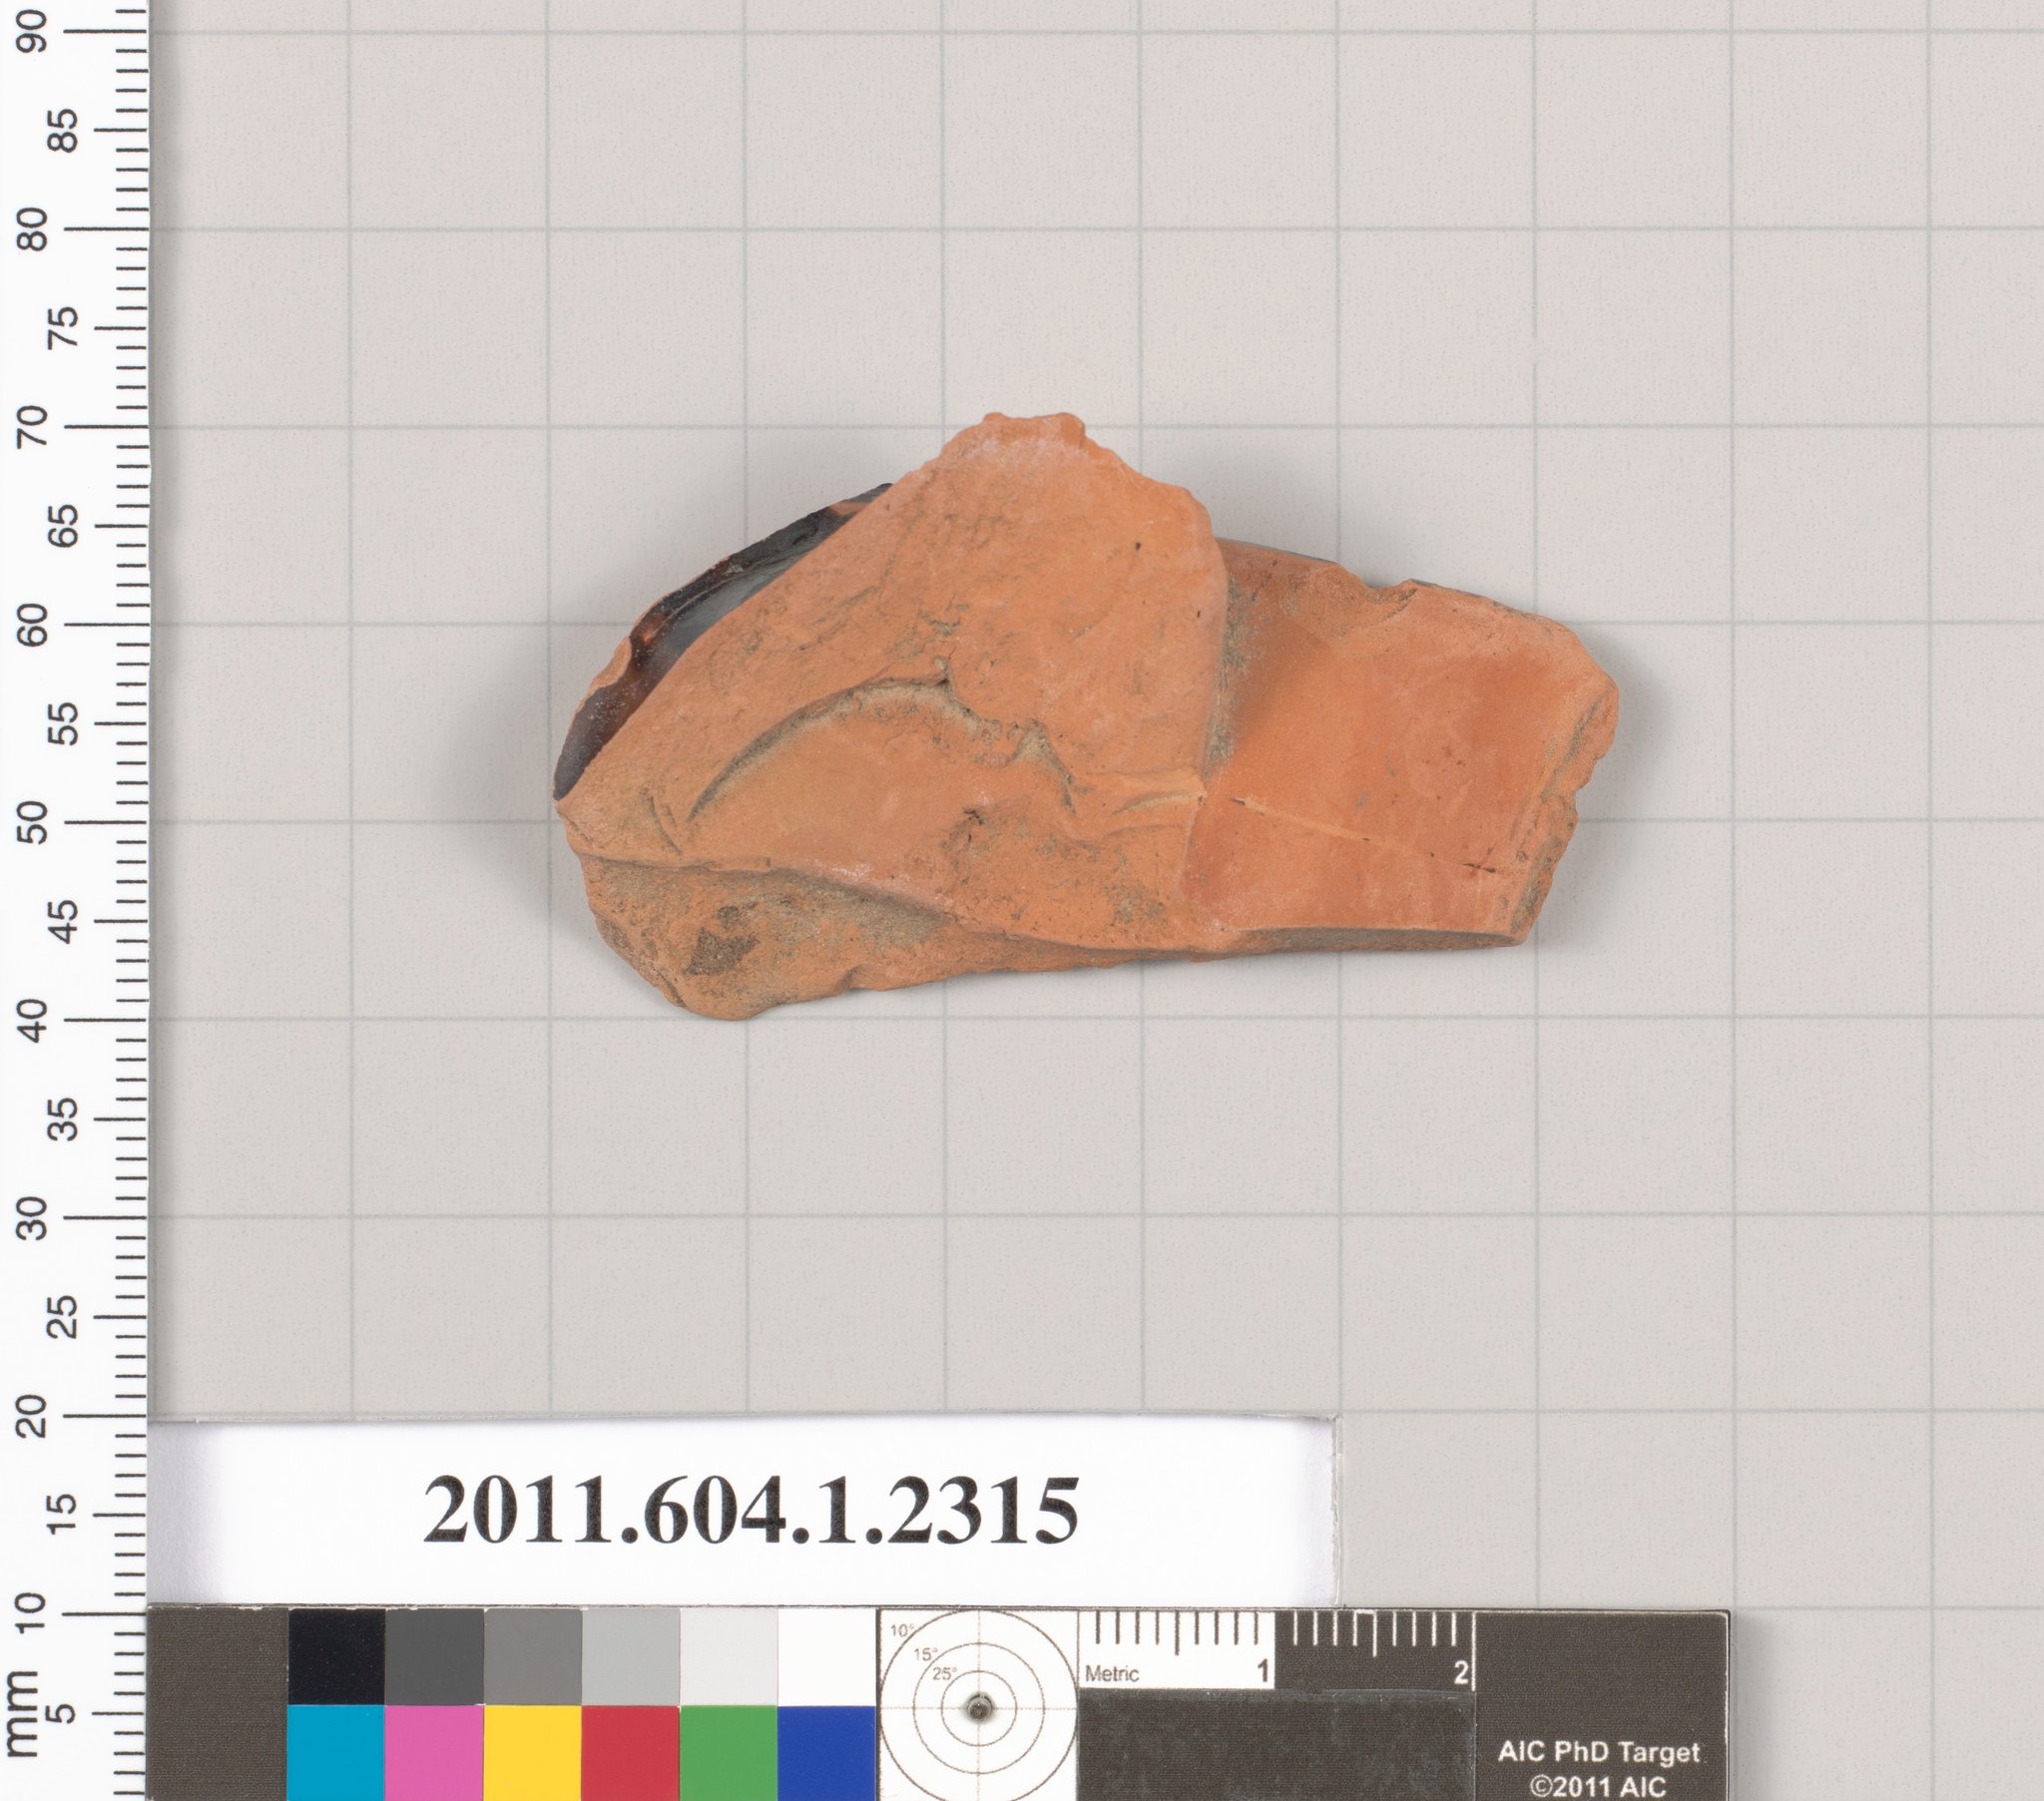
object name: kylix fragment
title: Terracotta fragment of a kylix (drinking cup)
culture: greek, attic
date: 500-451 BCE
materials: terracotta